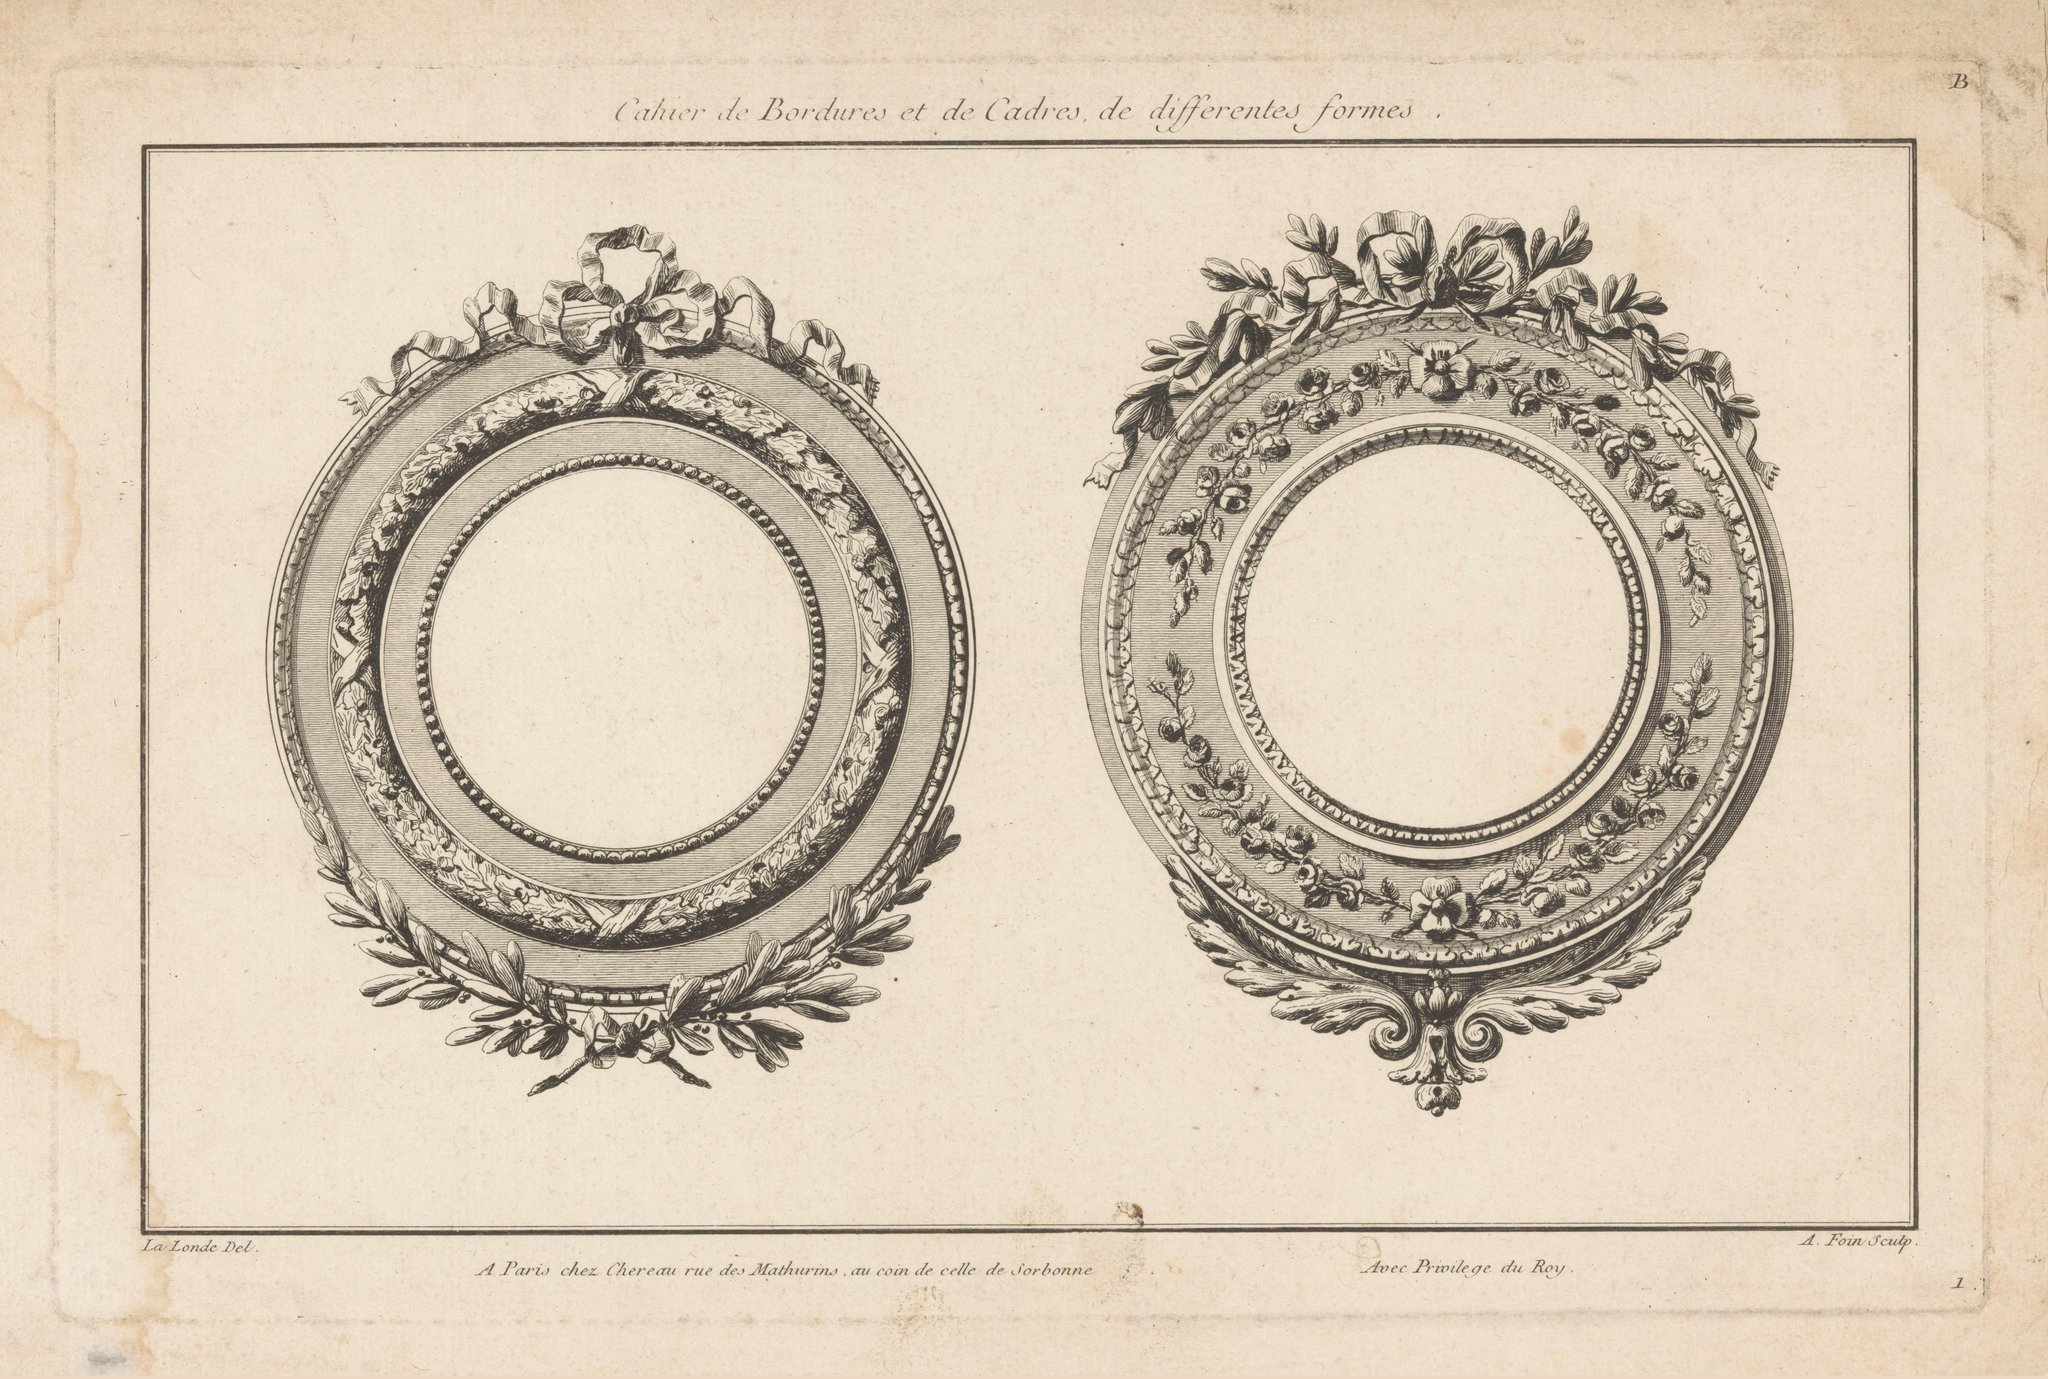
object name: print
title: Twee ronde omlijstingen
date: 1784-1785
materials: paper, pencil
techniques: engraving, etching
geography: paris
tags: ornaments ~ art (+ framing decorations)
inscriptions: collector's mark: Lugt 2228, collector's mark: Lugt 2760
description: Links een ronde omlijsting met bladmotieven en een lint, rechts een ronde omlijsting met bloem- en bladmotieven en een lint. Verso tekening van een arm.